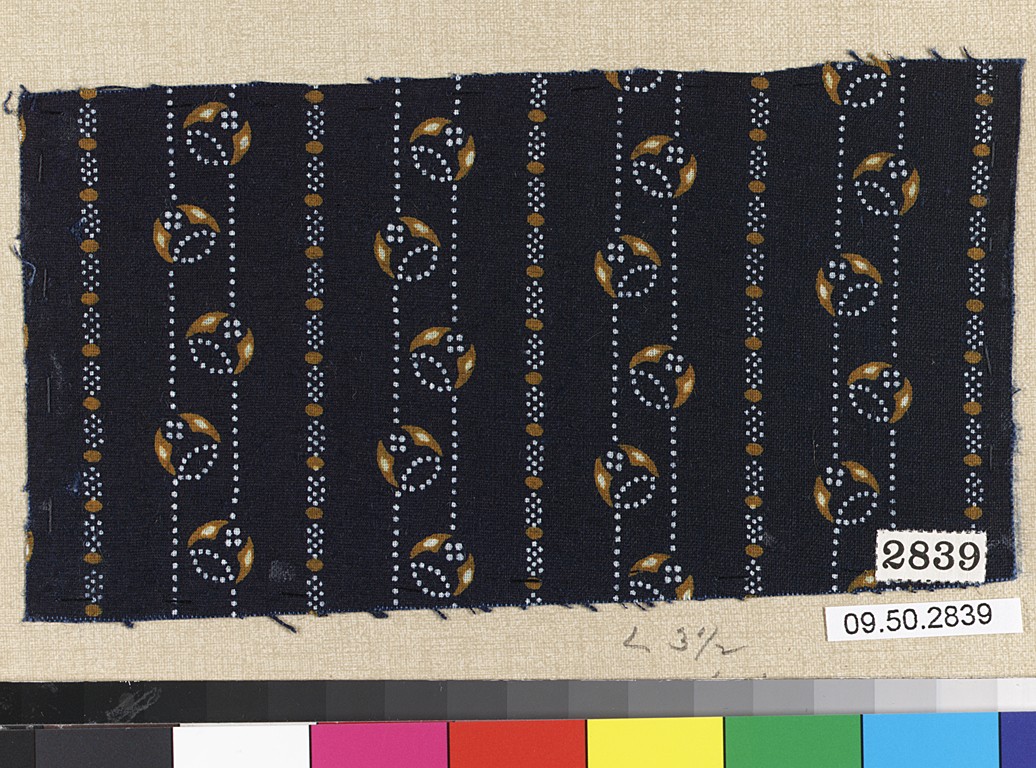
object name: piece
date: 1801-1900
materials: cotton